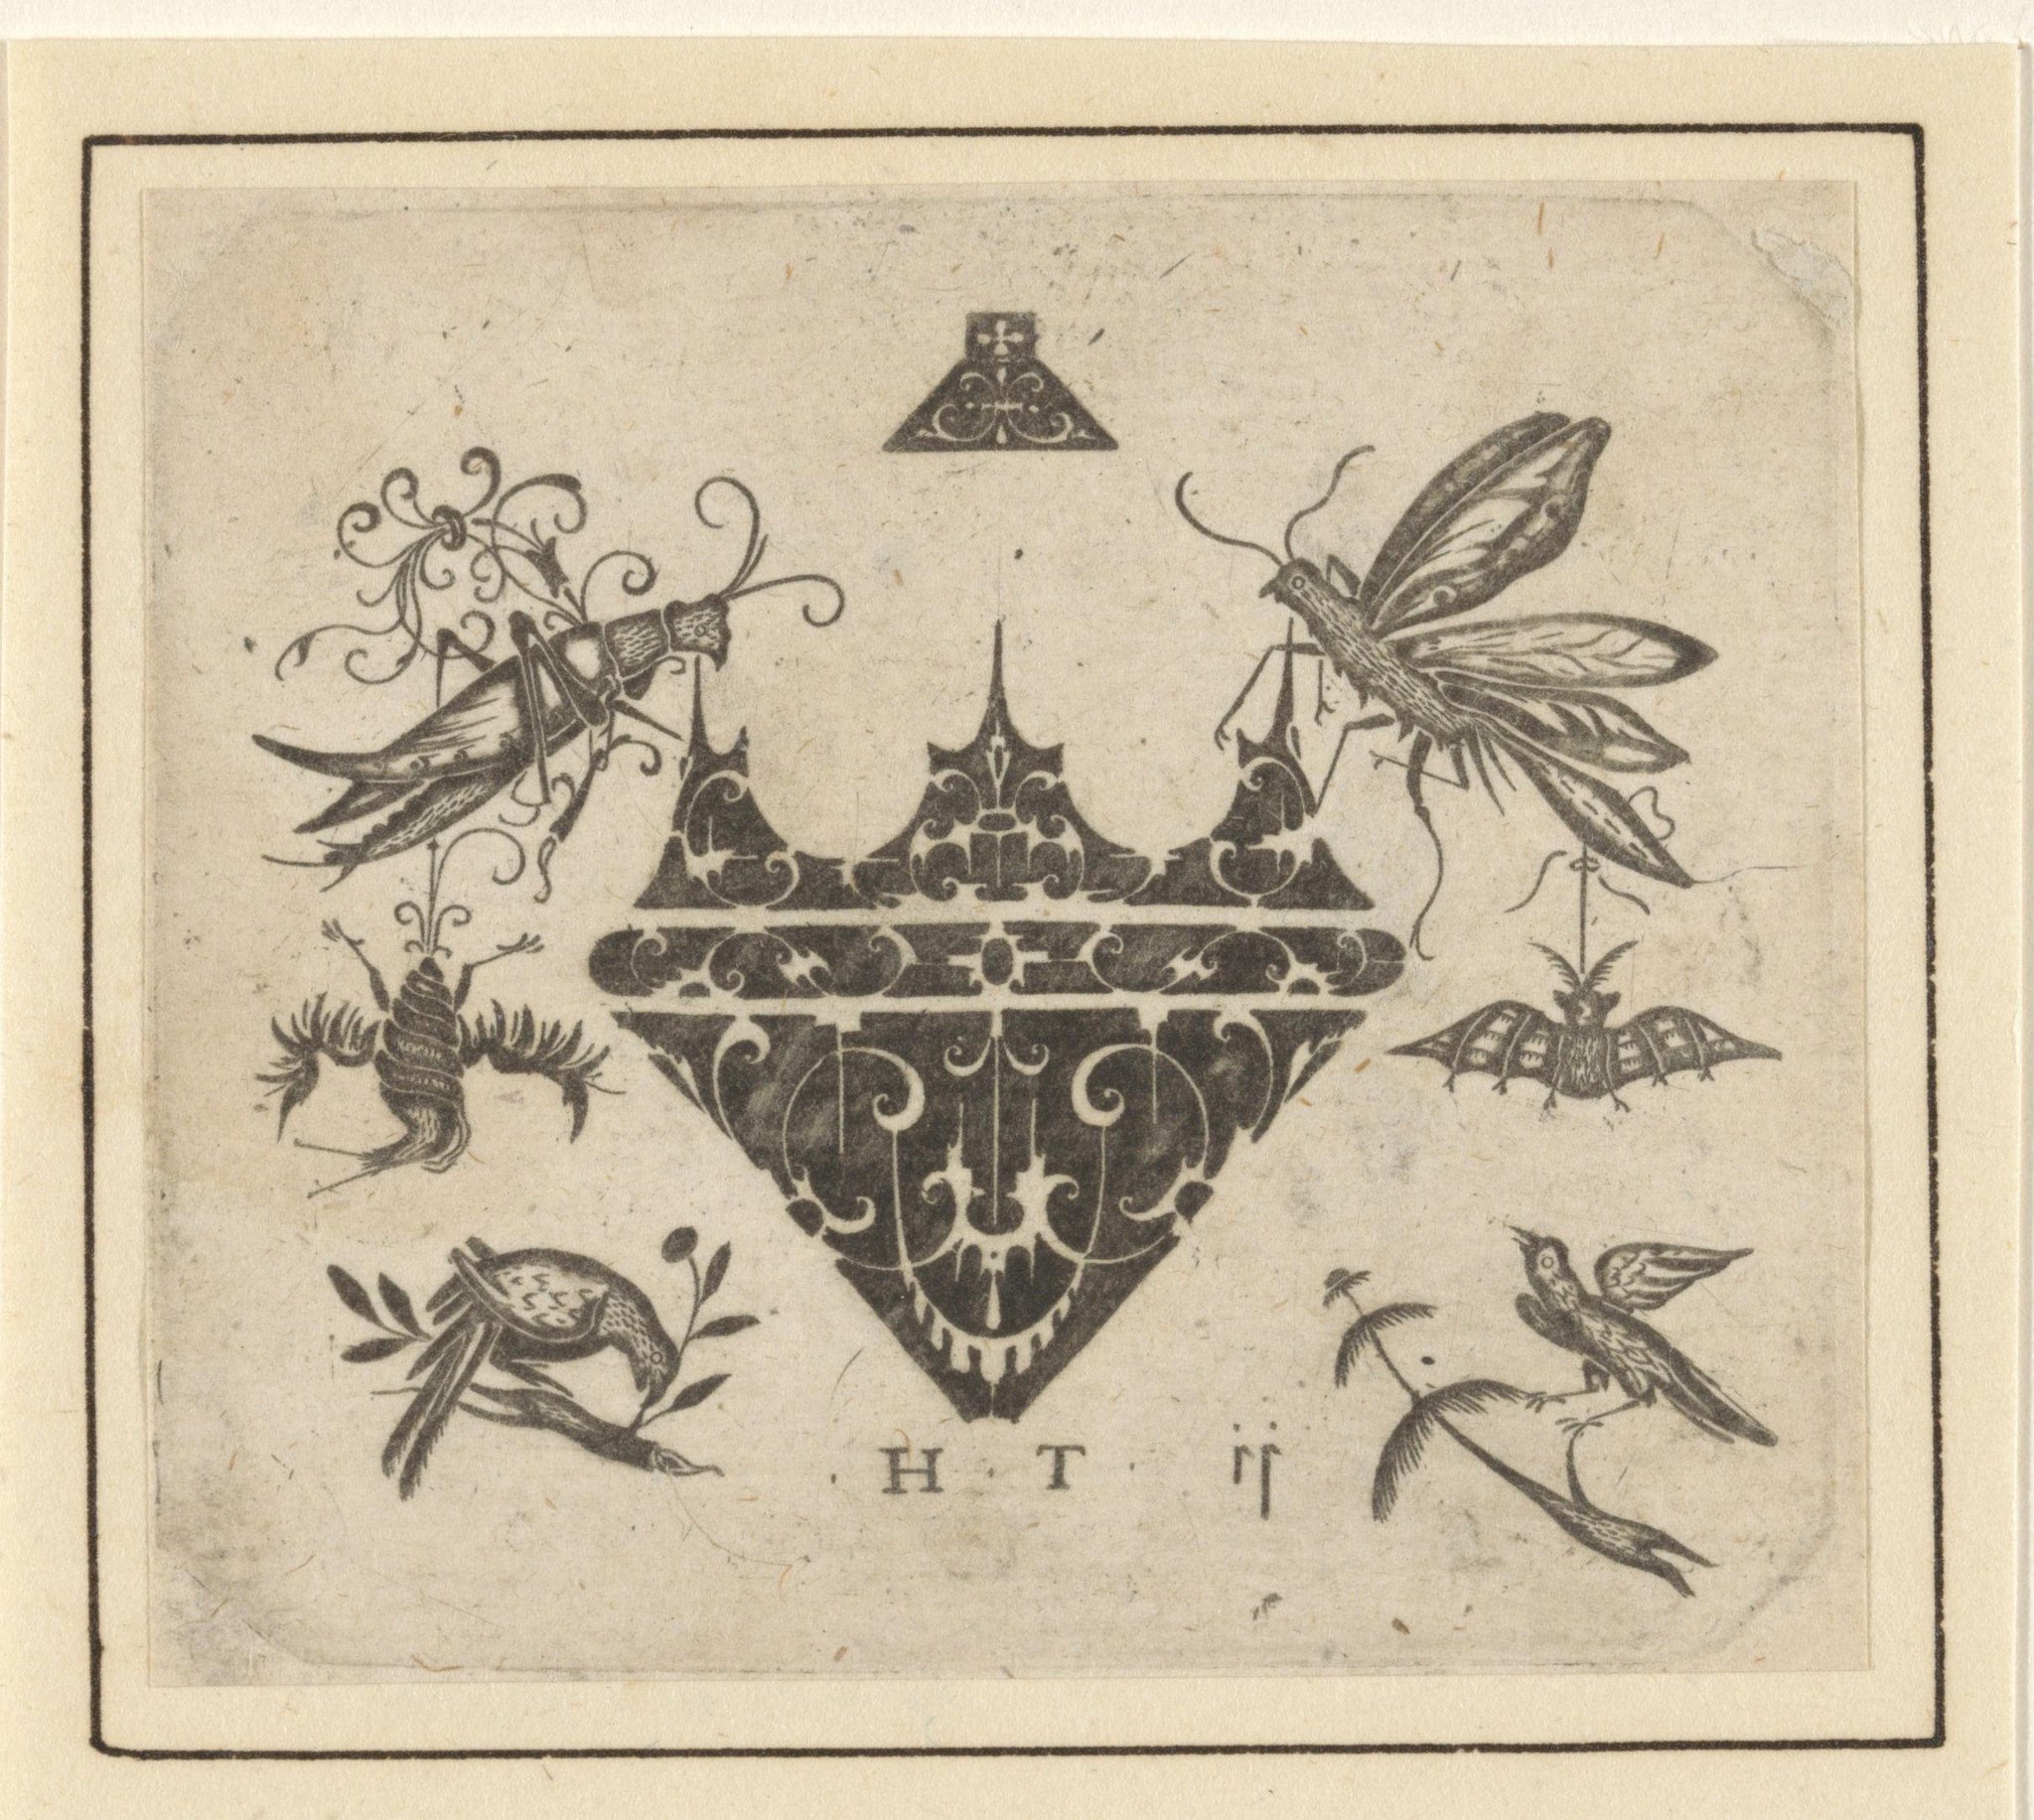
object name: ornament print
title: Ornament voor edelsmeedwerk met vogels, insecten en figuren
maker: henri toutin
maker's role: miniatuurschilder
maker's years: 1614-1683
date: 1628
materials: paper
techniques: engraving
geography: france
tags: ornaments ~ art, flying mammals: bat, birds, insects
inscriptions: collector's mark: Lugt 2760, collector's mark: Lugt 2228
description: Ornament voor edelsmeedwerk met vogels, insecten en figuren. Prent nr. 2 uit reeks van 7 gepubliceerd in 1628 onder vermelding van de leeftijd van de kunstenaar: 'á l'äge de 14 ans'.